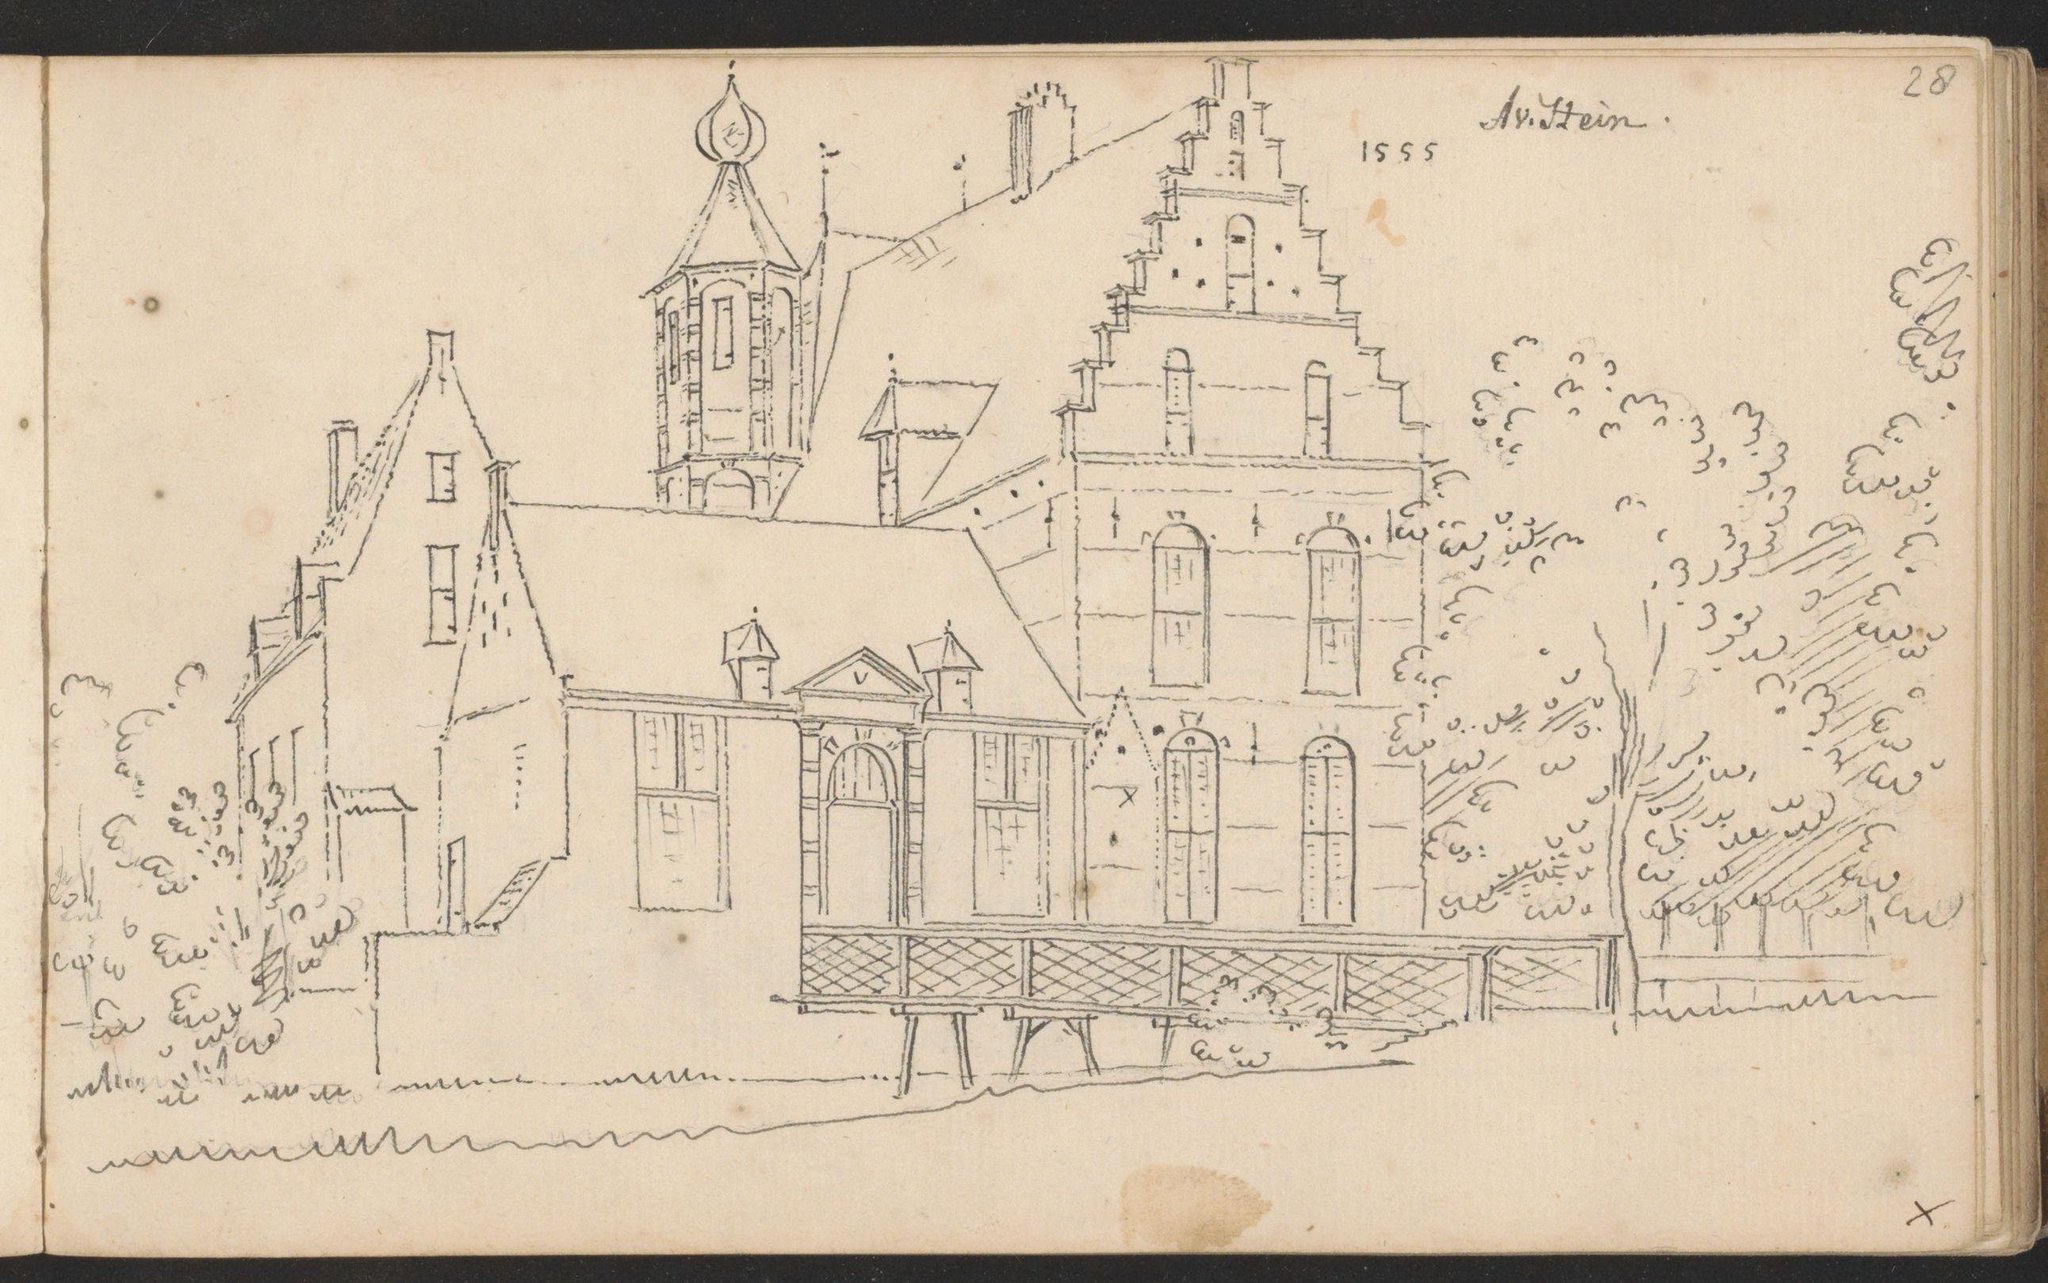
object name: sketchbook leaf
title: Kasteel Avestein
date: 1701-1759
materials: ink, paper, pencil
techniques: pen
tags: castle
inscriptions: annotation: ‘1555 Avestein’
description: Blad 28 recto uit een schetsboek met 65 bladen.